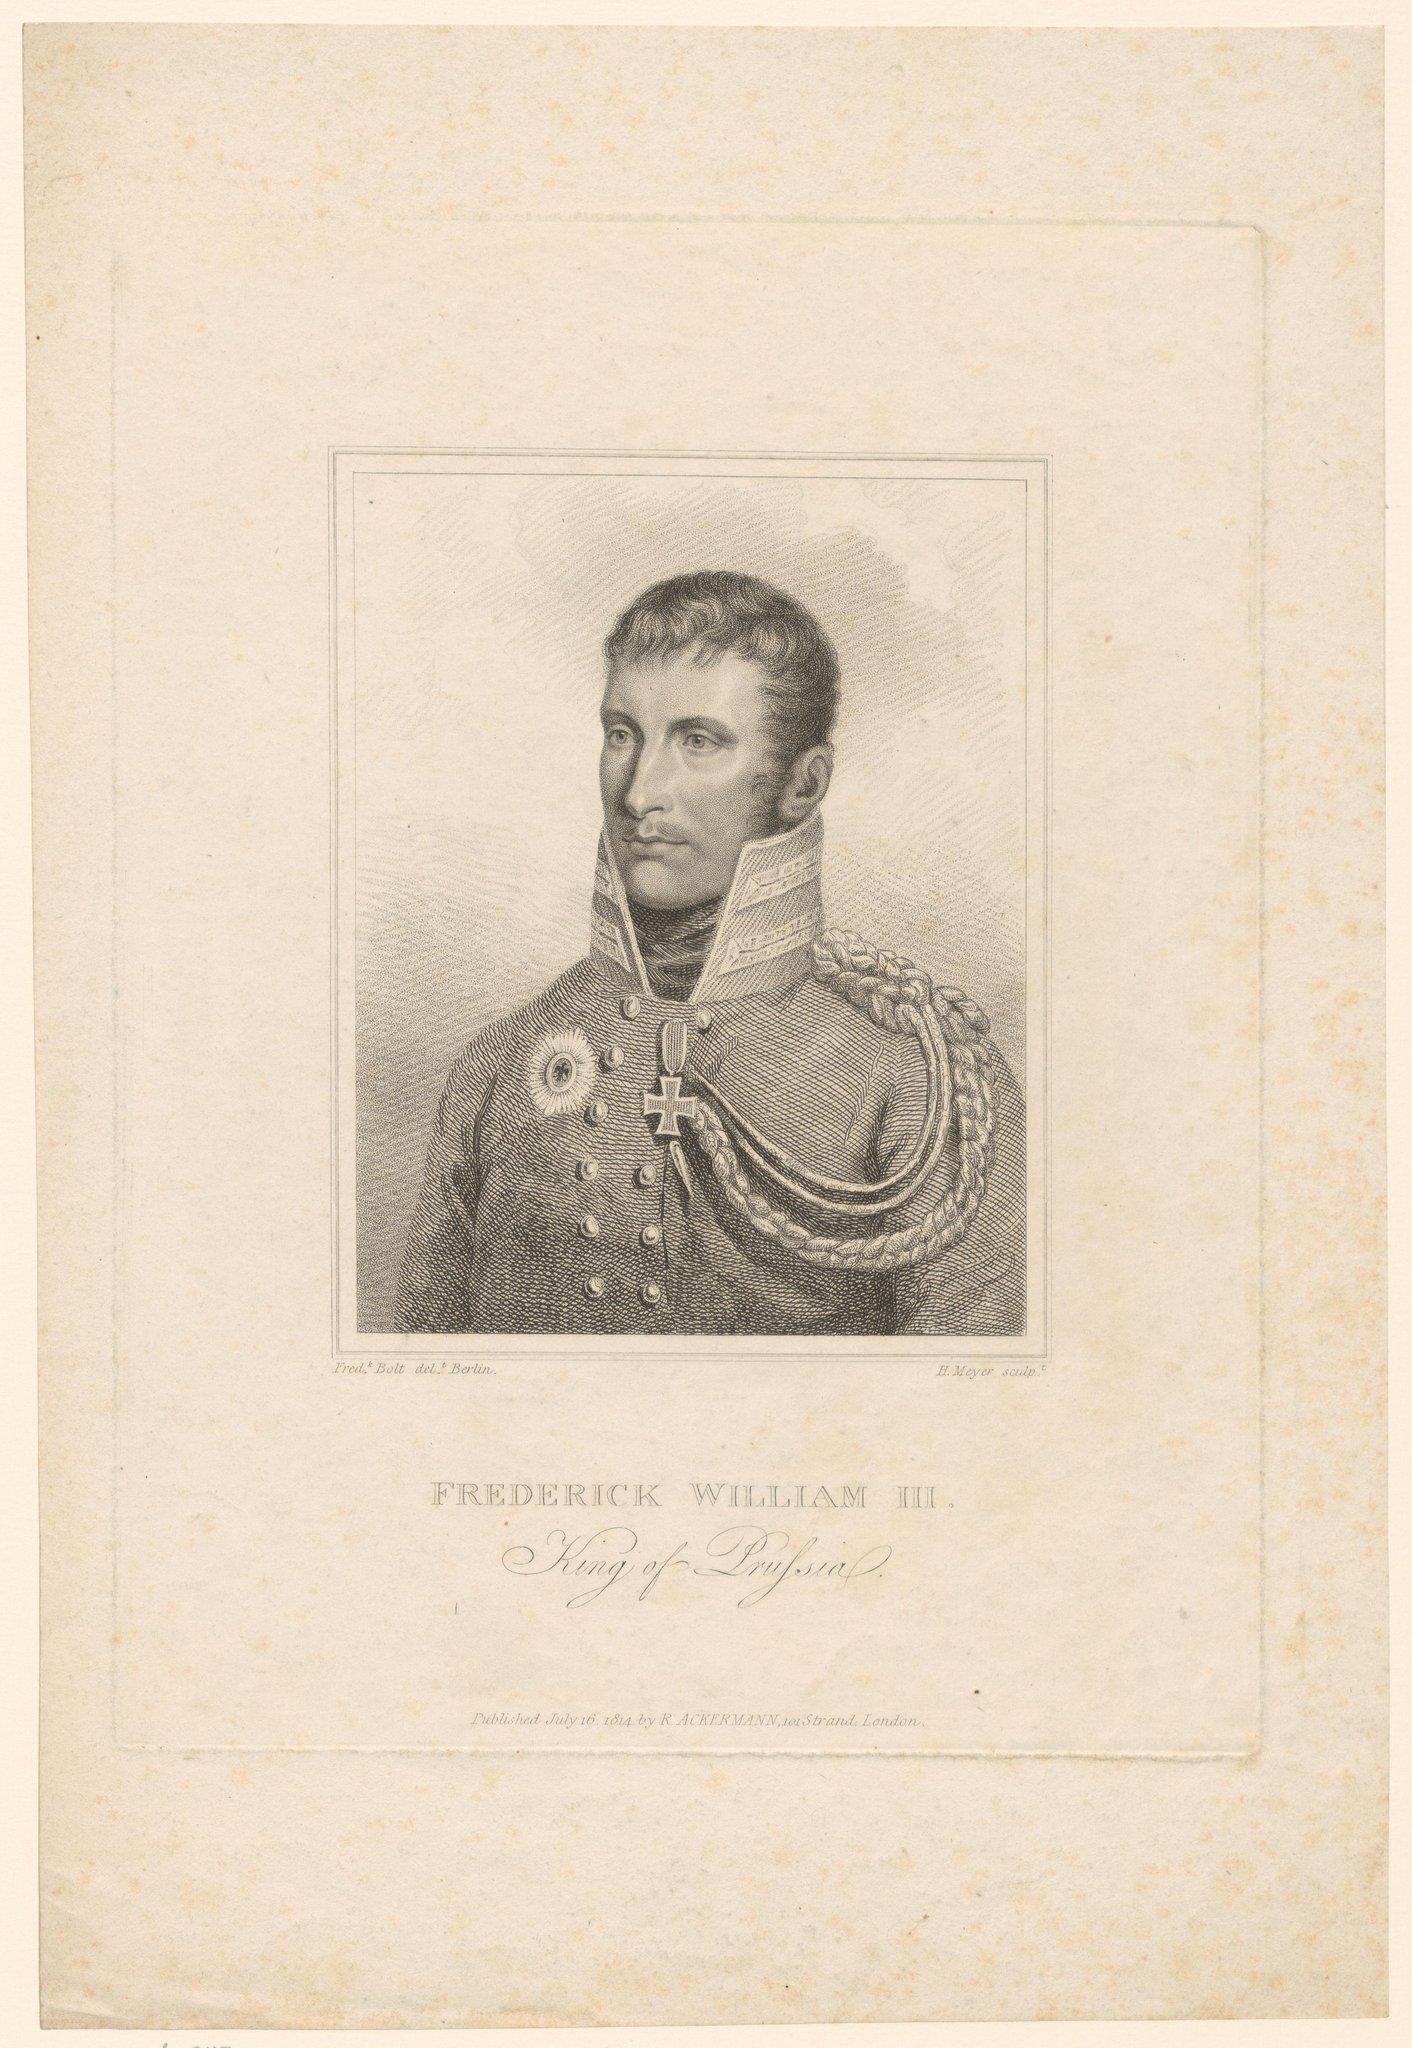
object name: print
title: Frederick William III, King of Prussia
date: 1807-1814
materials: paper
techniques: etching, roulette, engraving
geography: london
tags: berlin, frederik willem iii koning van pruisen, historical persons, king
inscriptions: collector's mark: Lugt 2228